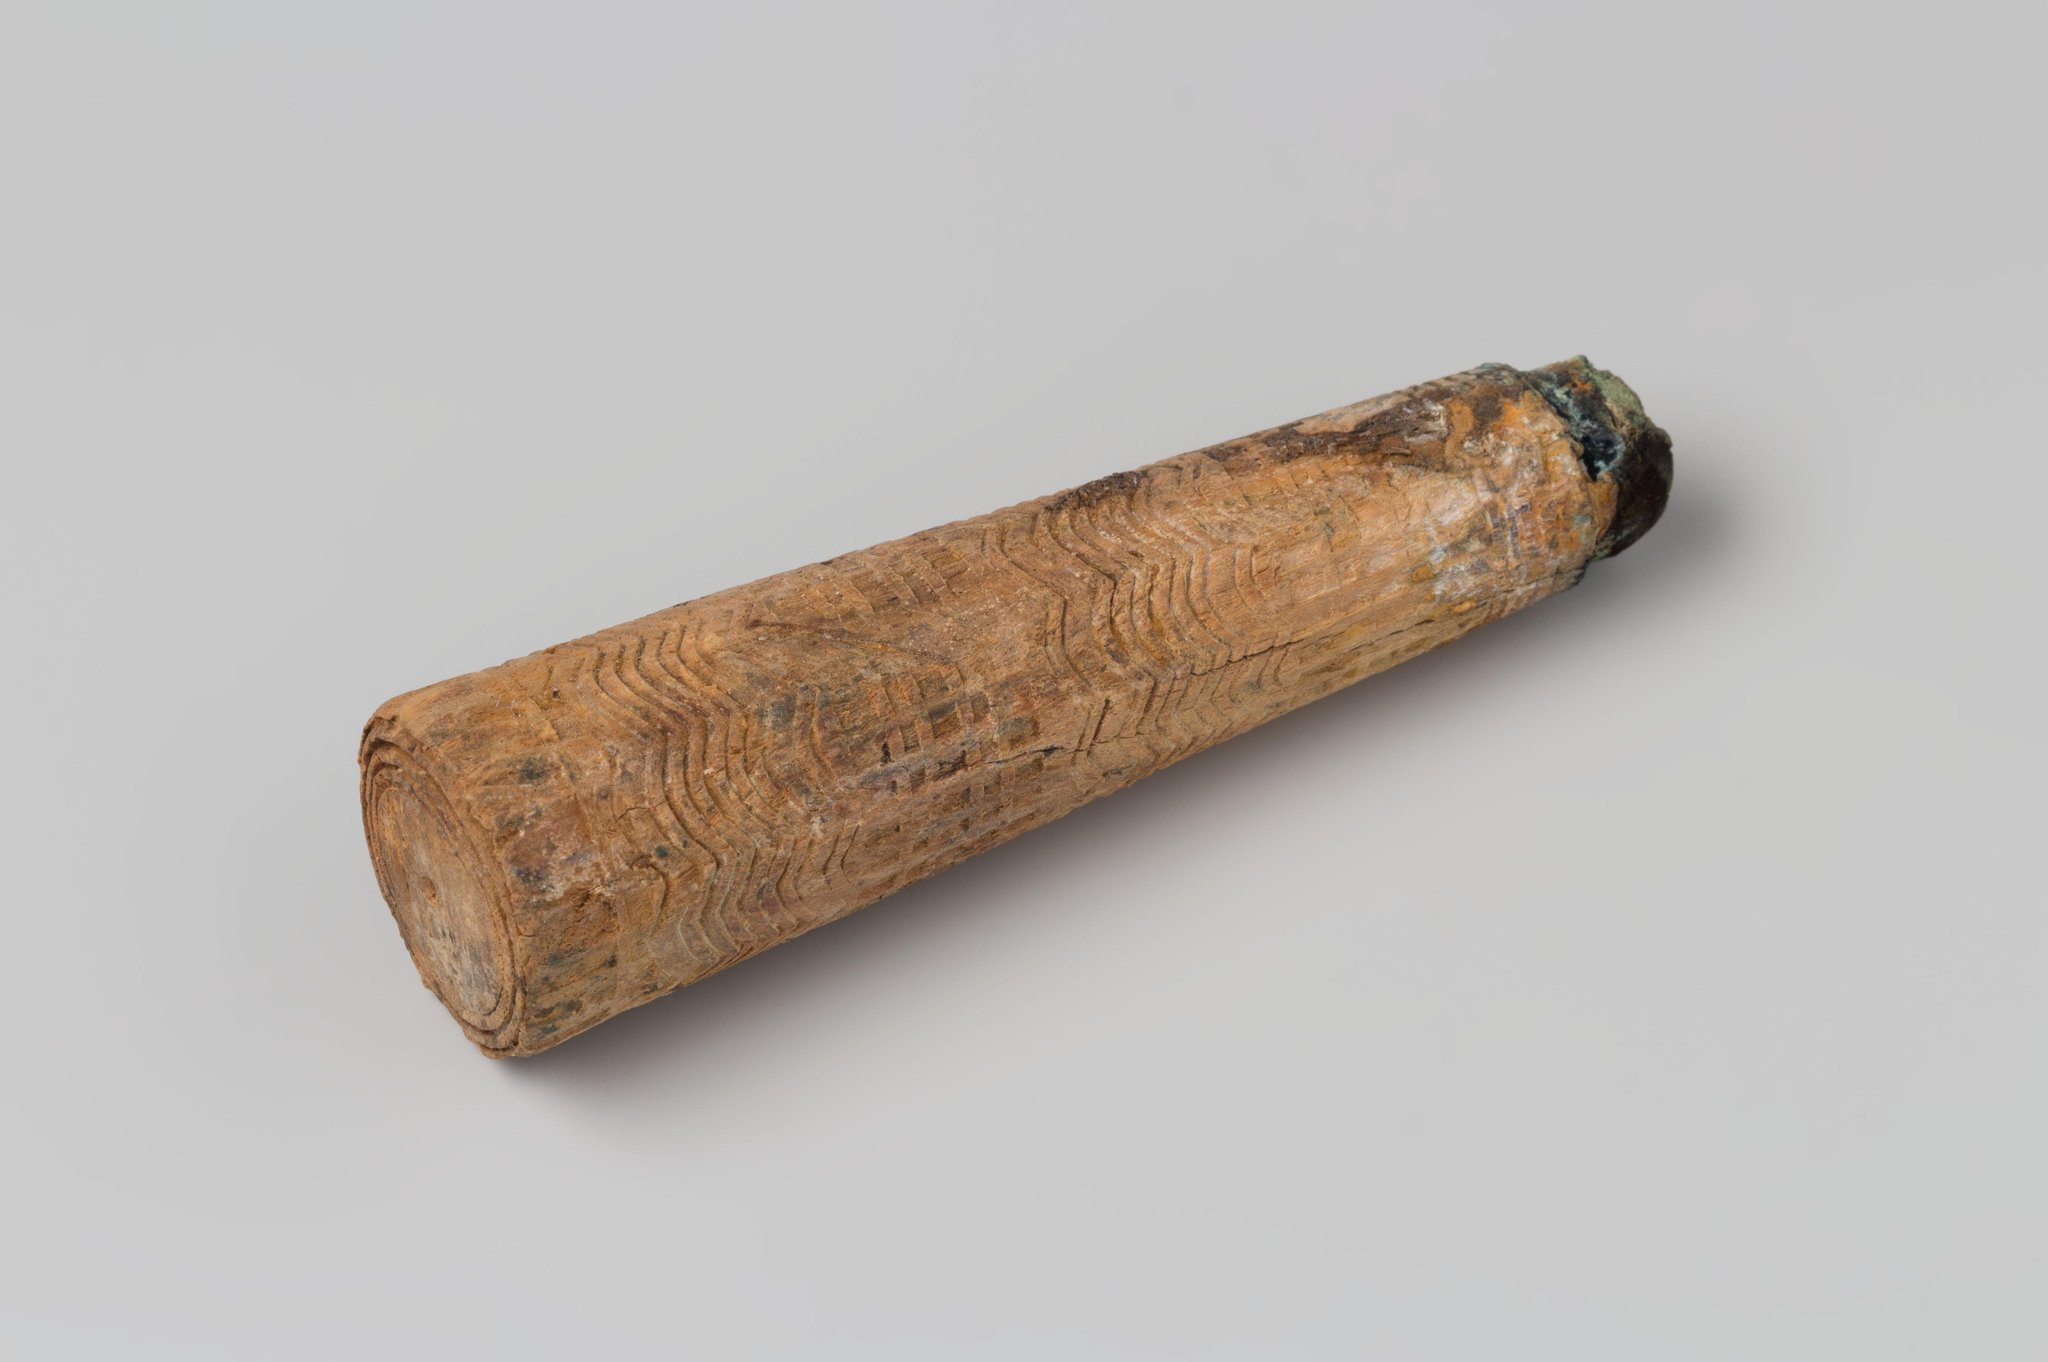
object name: knife handle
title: Messenheft uit het wrak van de Oost-Indiëvaarder Hollandia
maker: Anonymous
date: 1700-1743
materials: copper, wood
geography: netherlands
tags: verenigde oostindische compagnie, hollandia (schip), annet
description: Knife, handle, cylindrical: tapering; id. NG 1979-403H, ferrule, id. NG 1980-27H426.